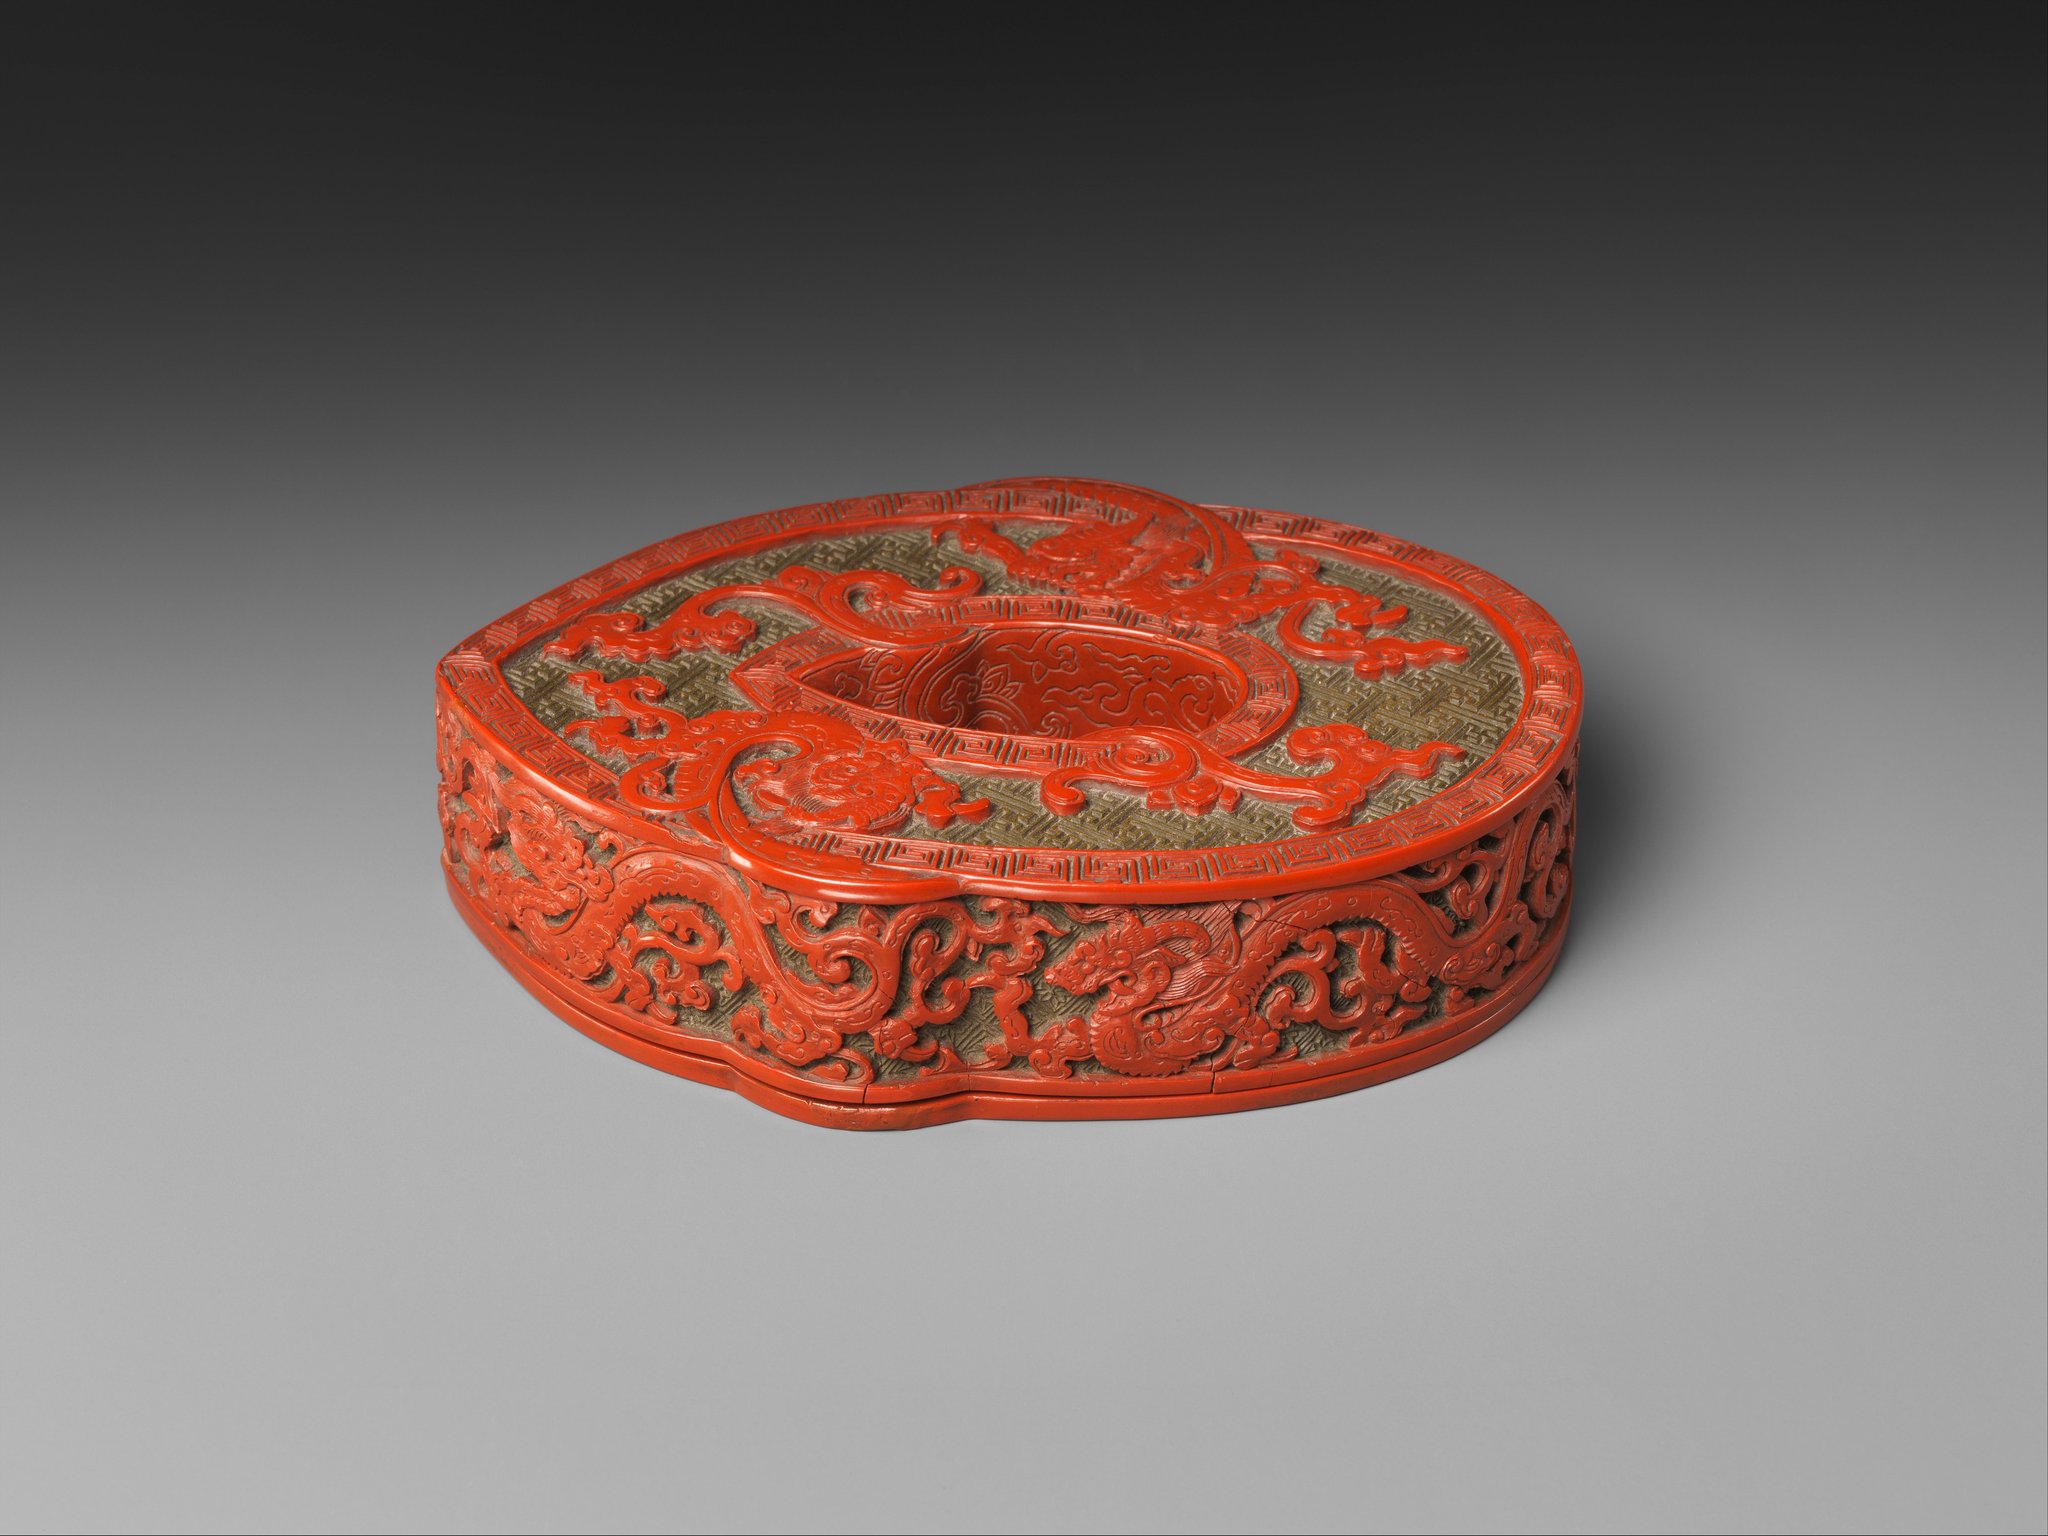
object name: box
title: Box in the shape of an archaic jade she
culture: chinese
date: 1734-1766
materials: lacquer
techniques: carving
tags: dragons